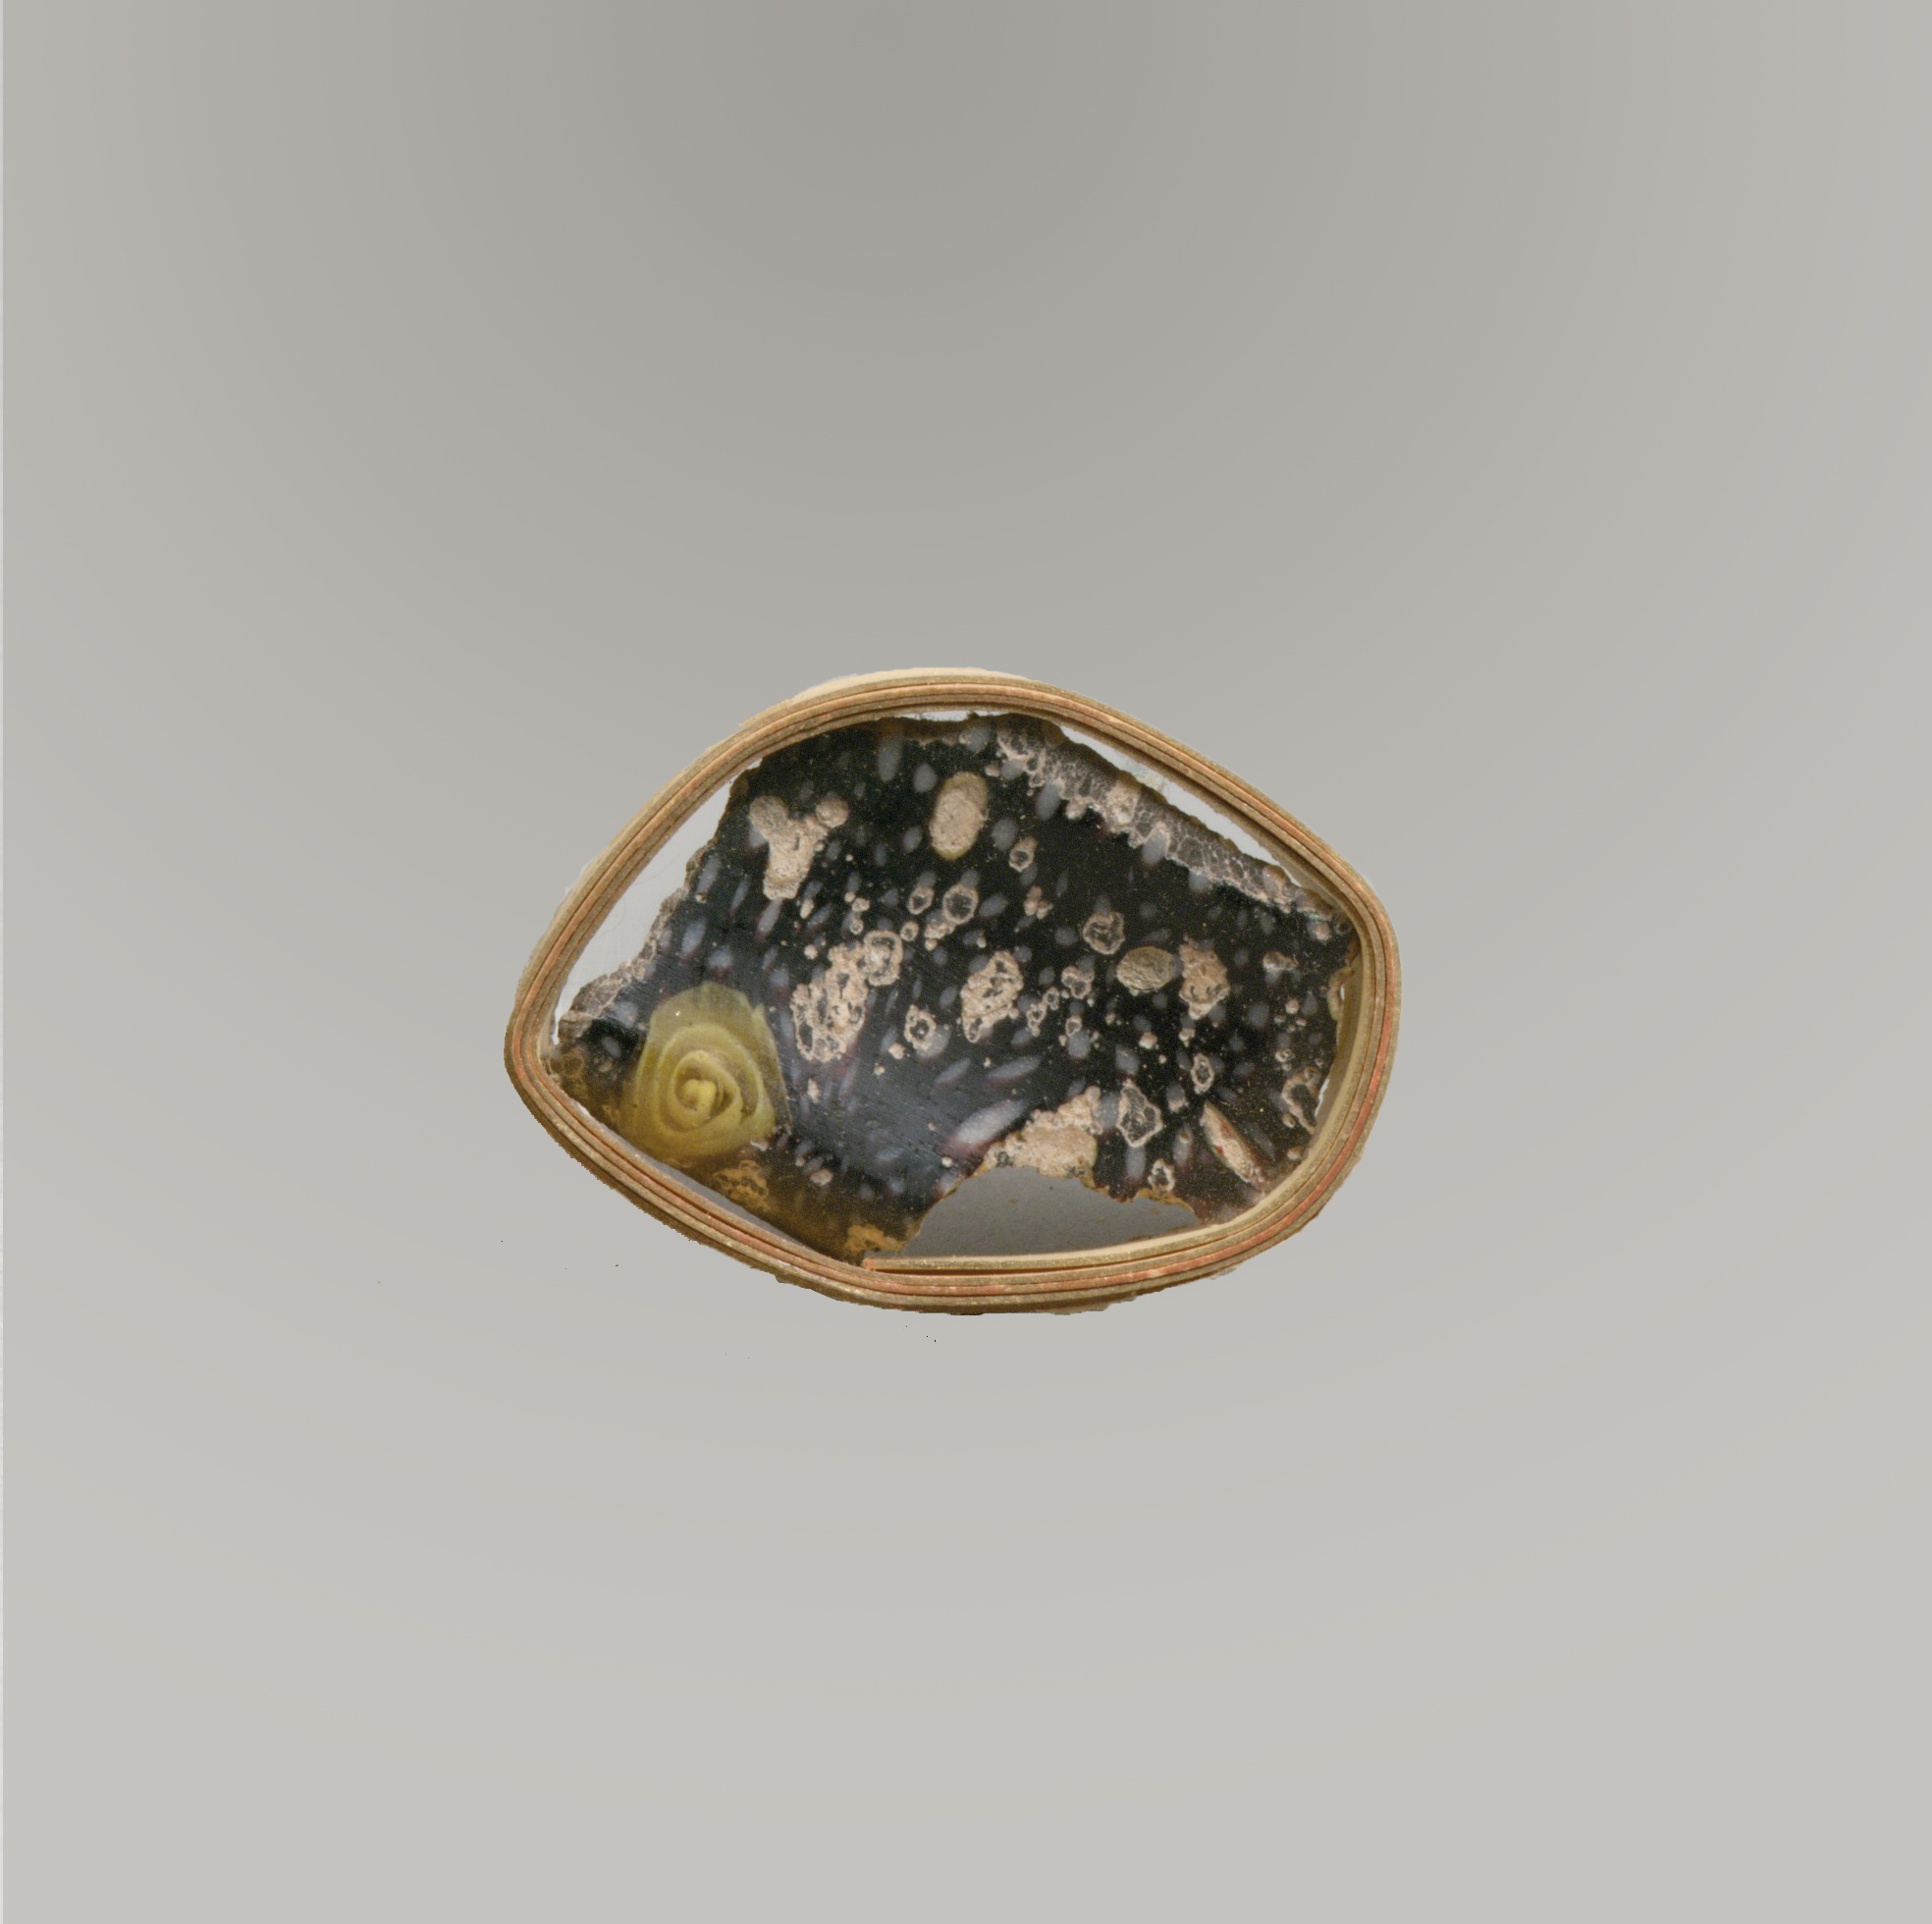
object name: fragment, mosaic bowl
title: Glass mosaic carinated bowl fragment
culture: roman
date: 34 BCE-33 CE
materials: glass